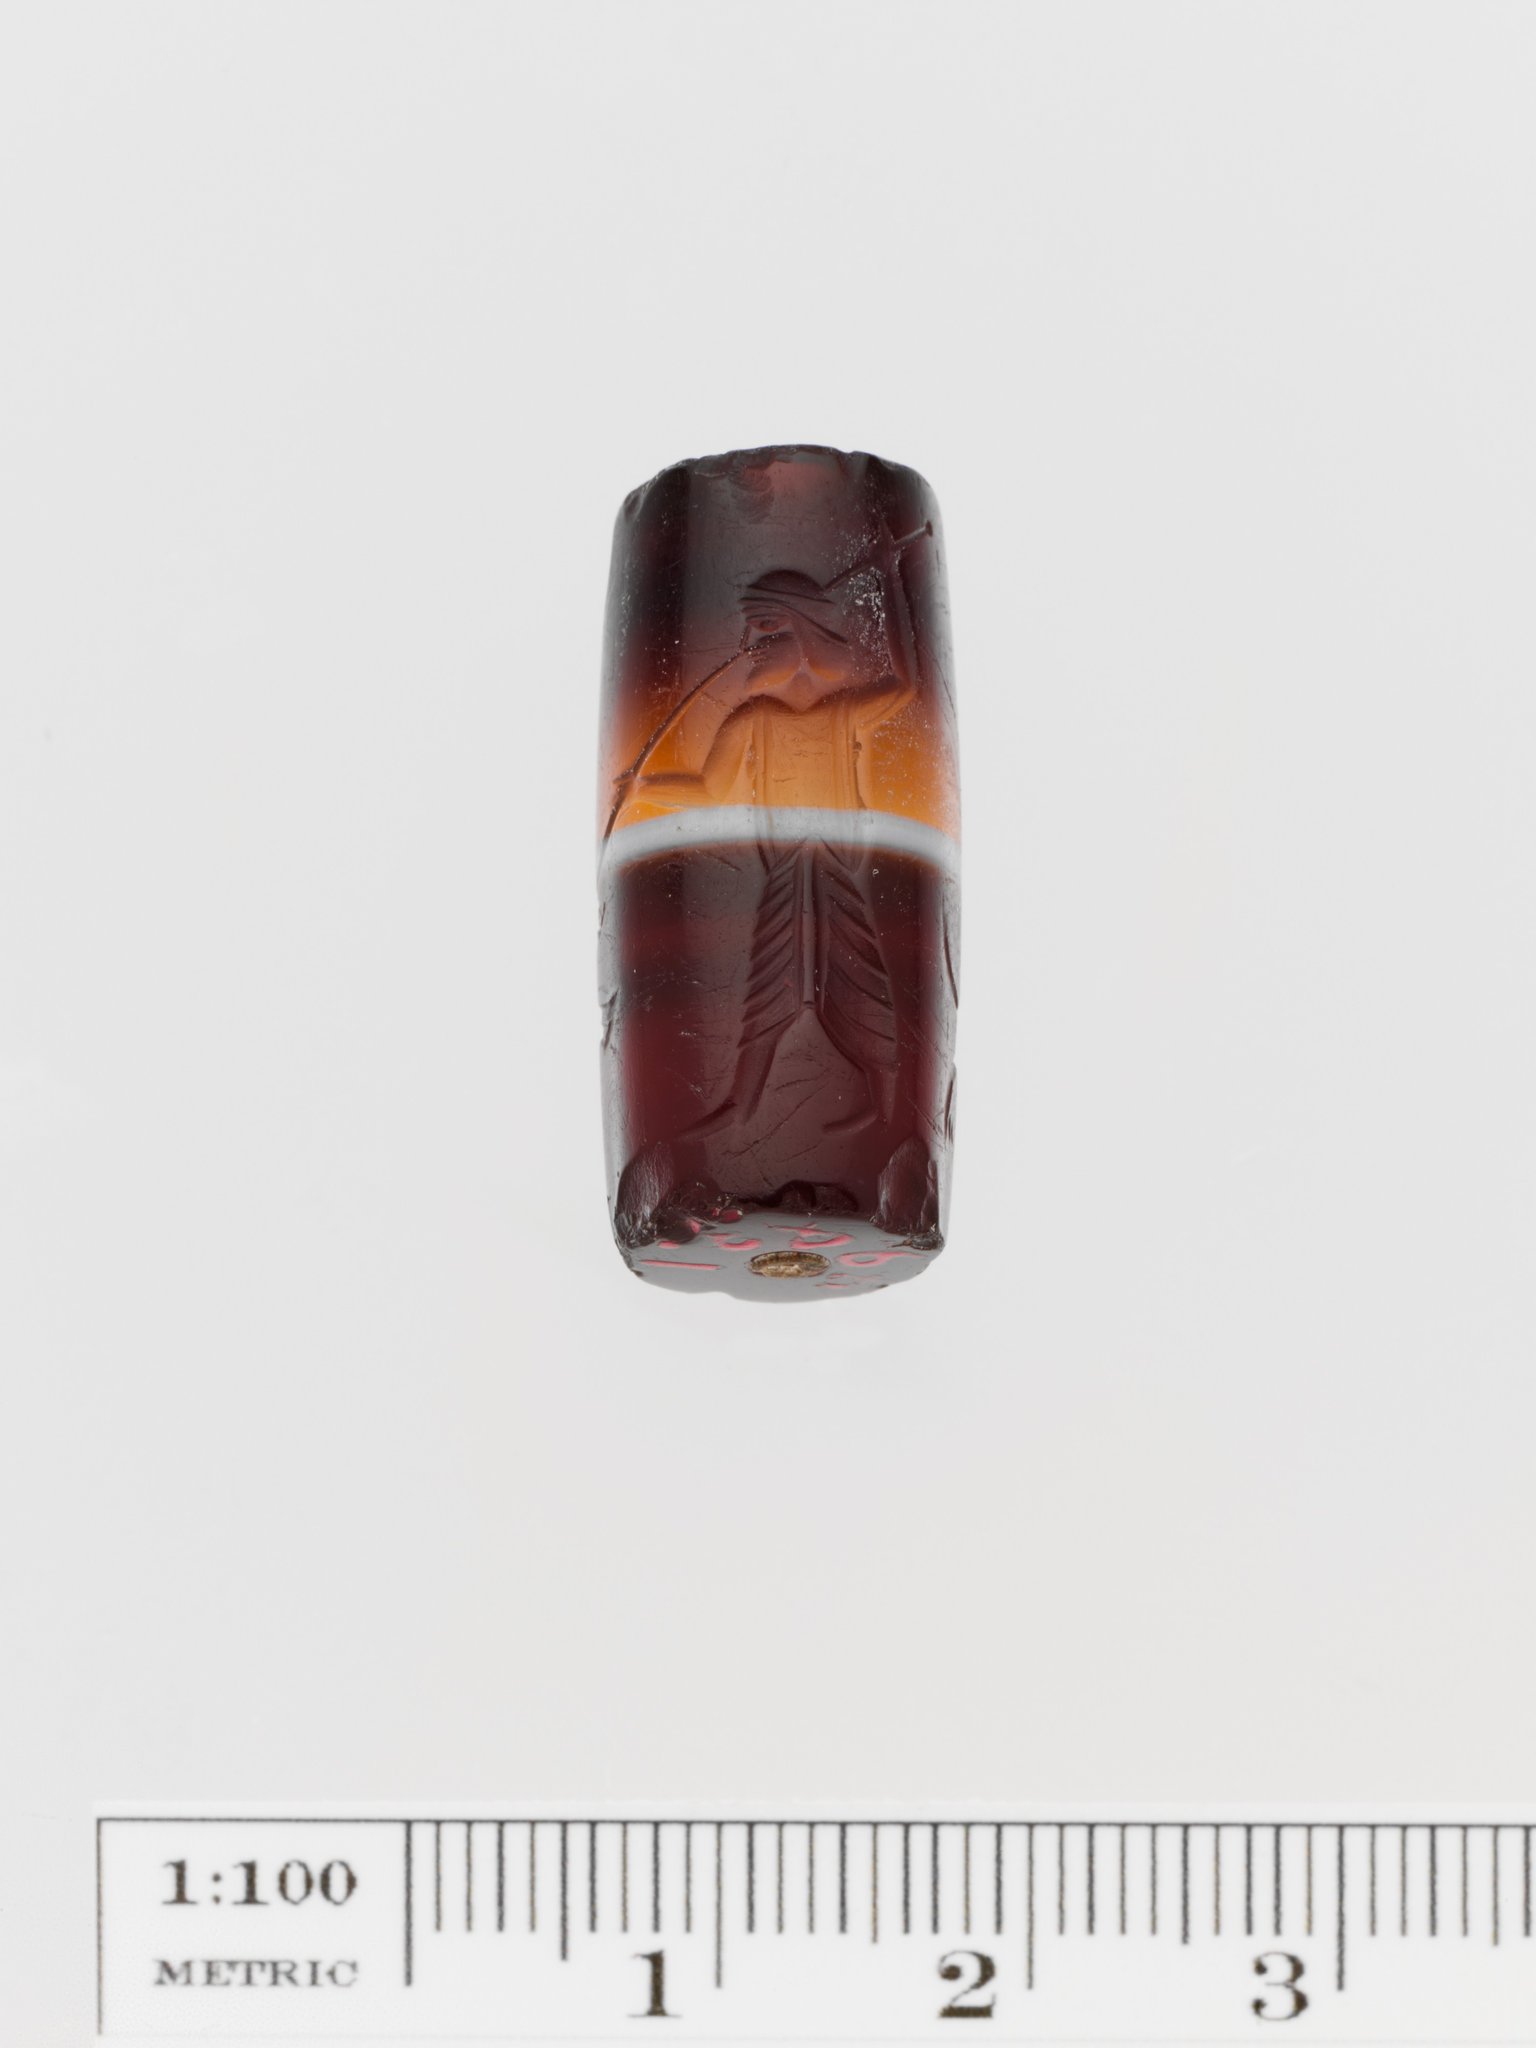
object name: seal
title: Banded agate cylinder seal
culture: greek, ionian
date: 450-400 BCE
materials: stone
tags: men,boars,dogs